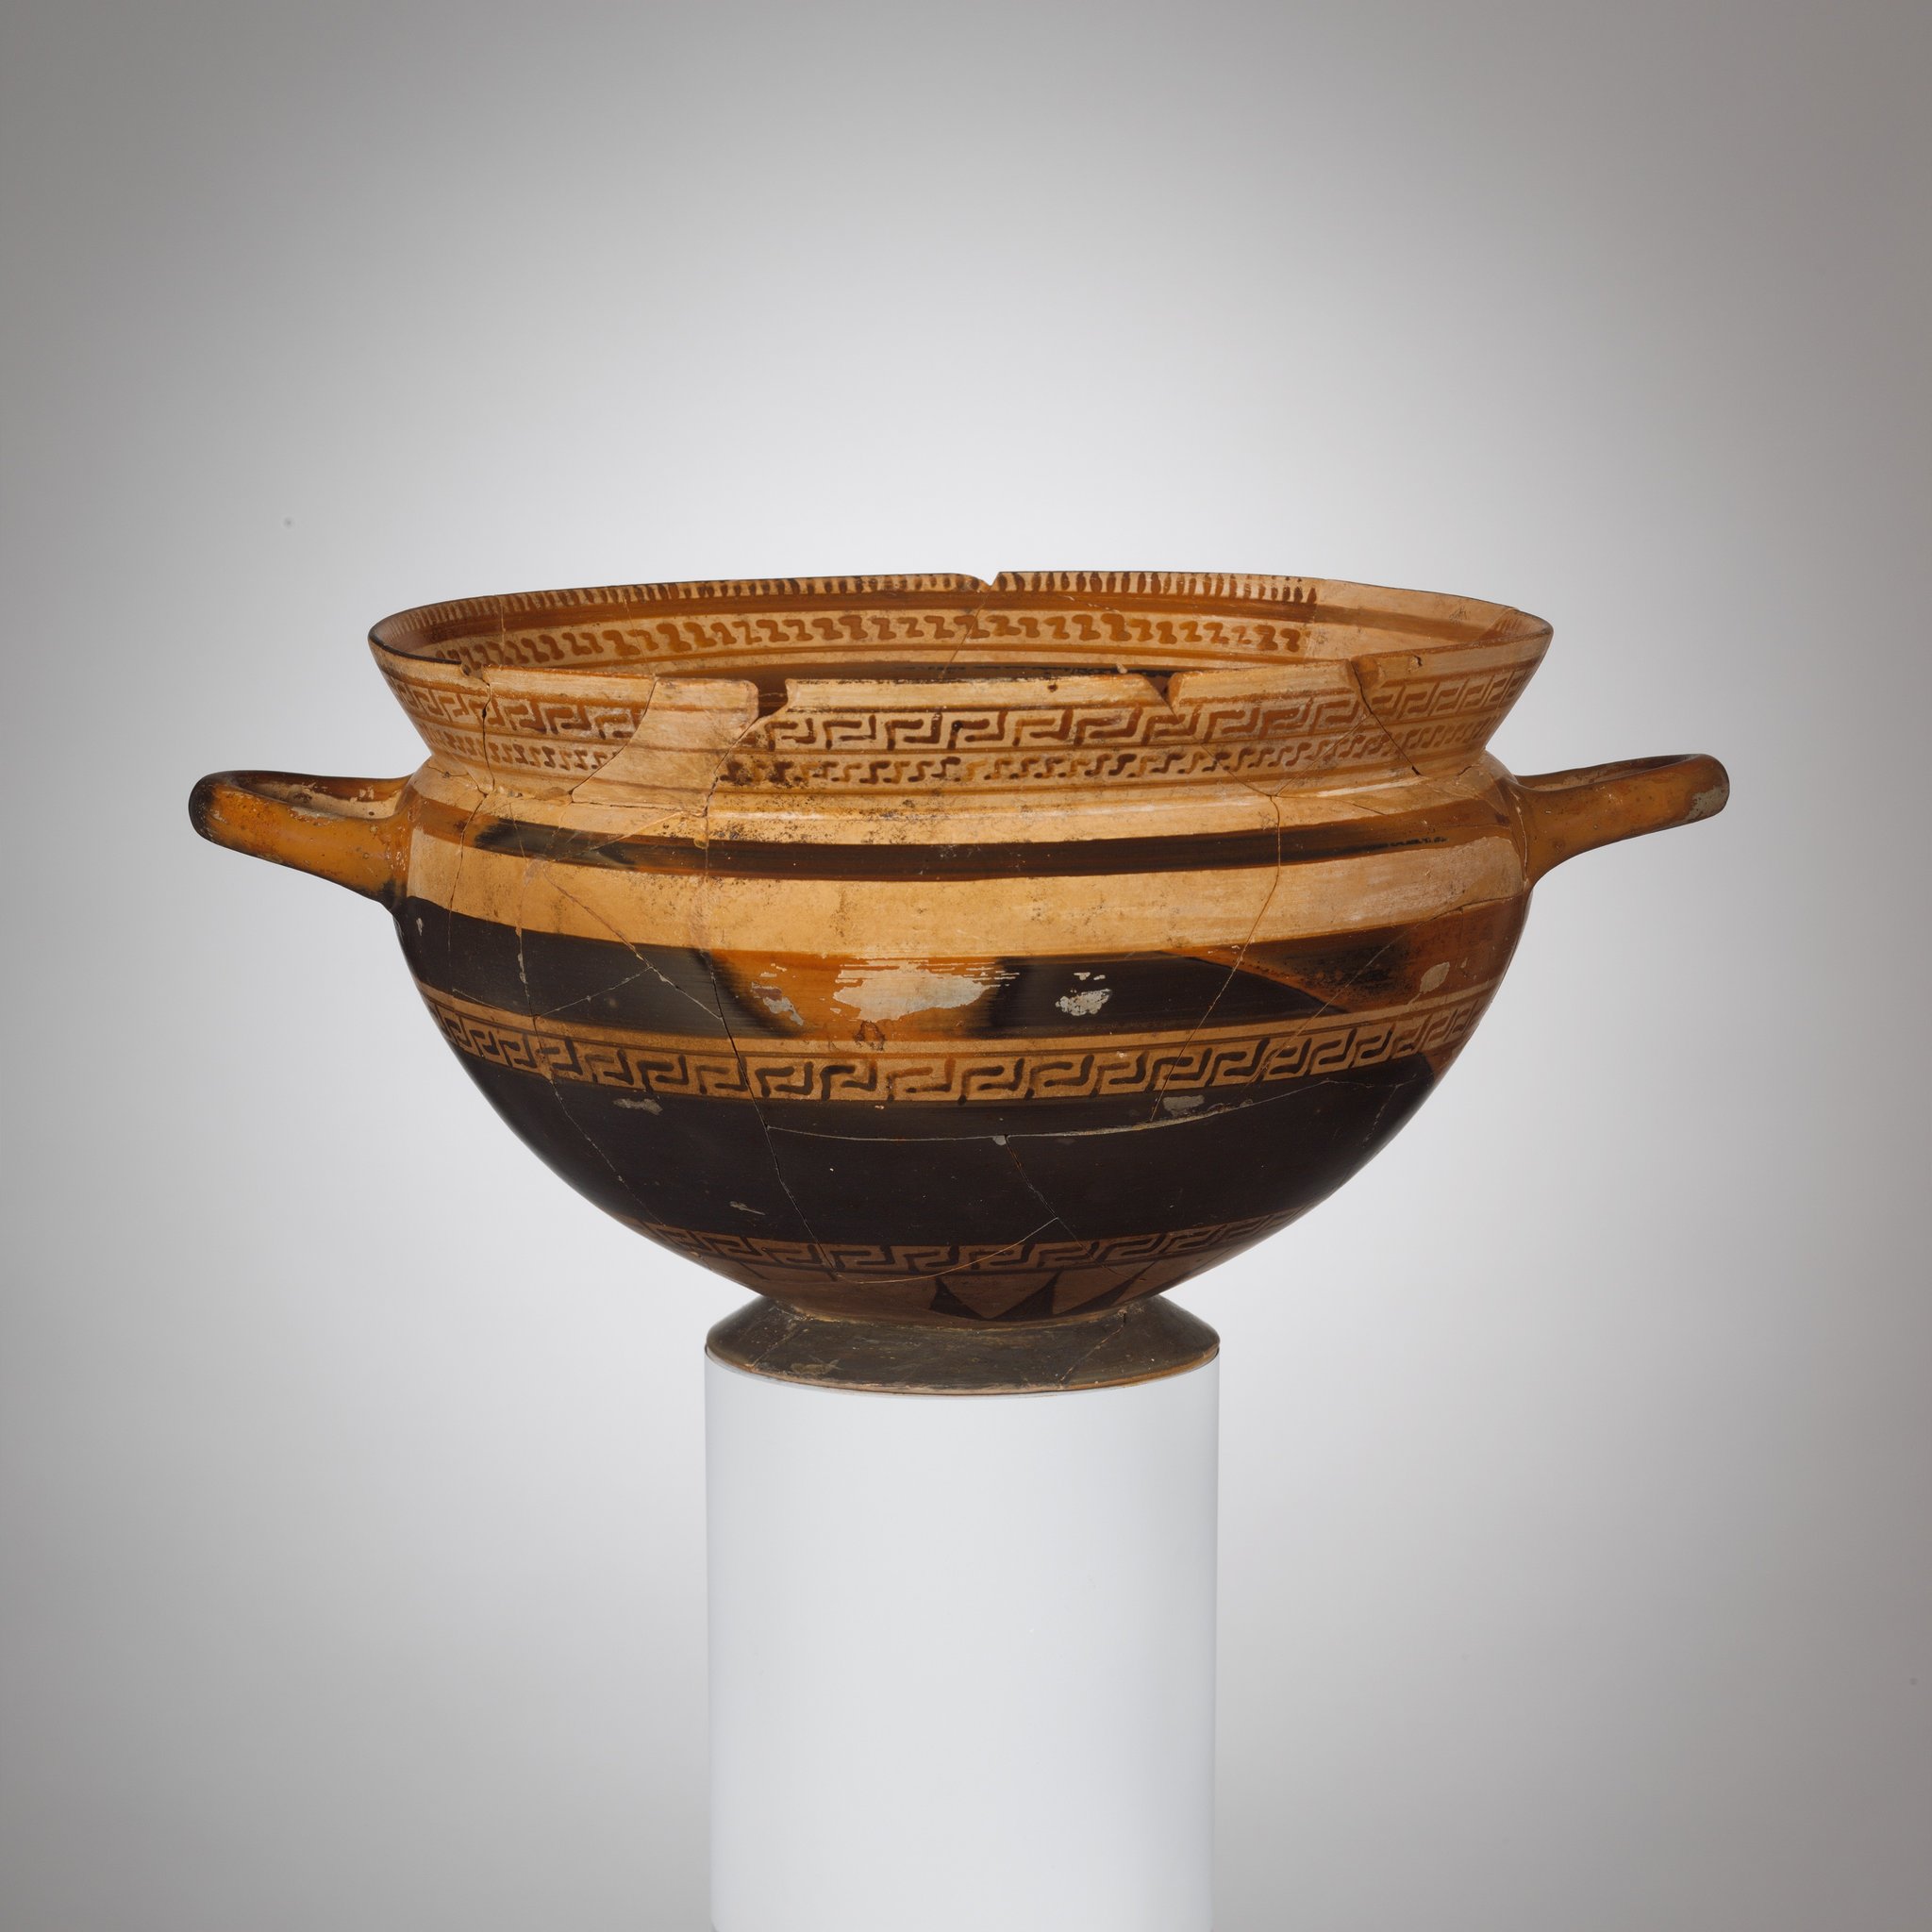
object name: skyphos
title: Terracotta skyphos (deep drinking cup)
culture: east greek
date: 634-568 BCE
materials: terracotta